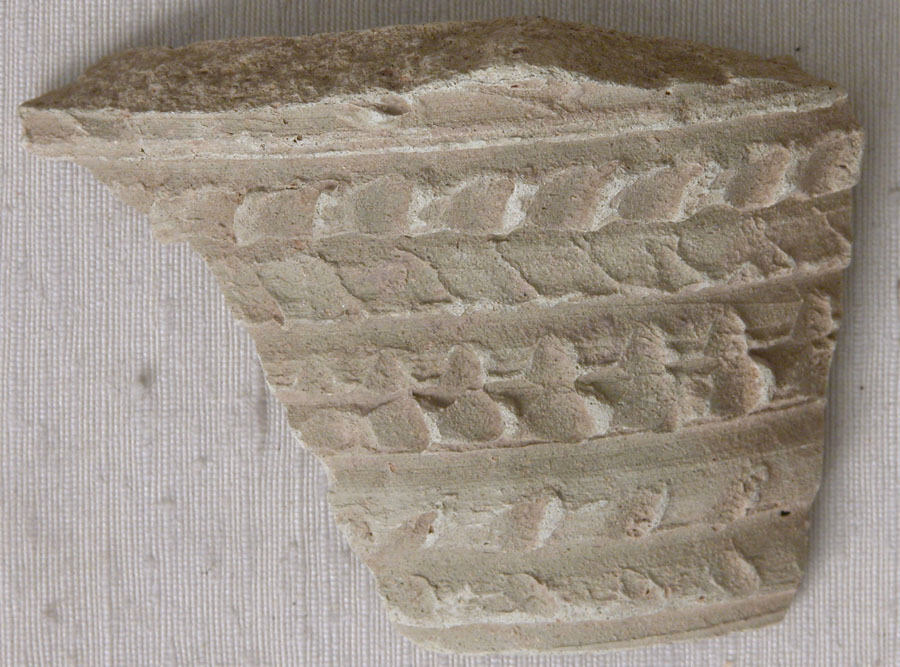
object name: fragment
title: Ceramic Fragment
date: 701-900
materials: earthenware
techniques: molding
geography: iraq